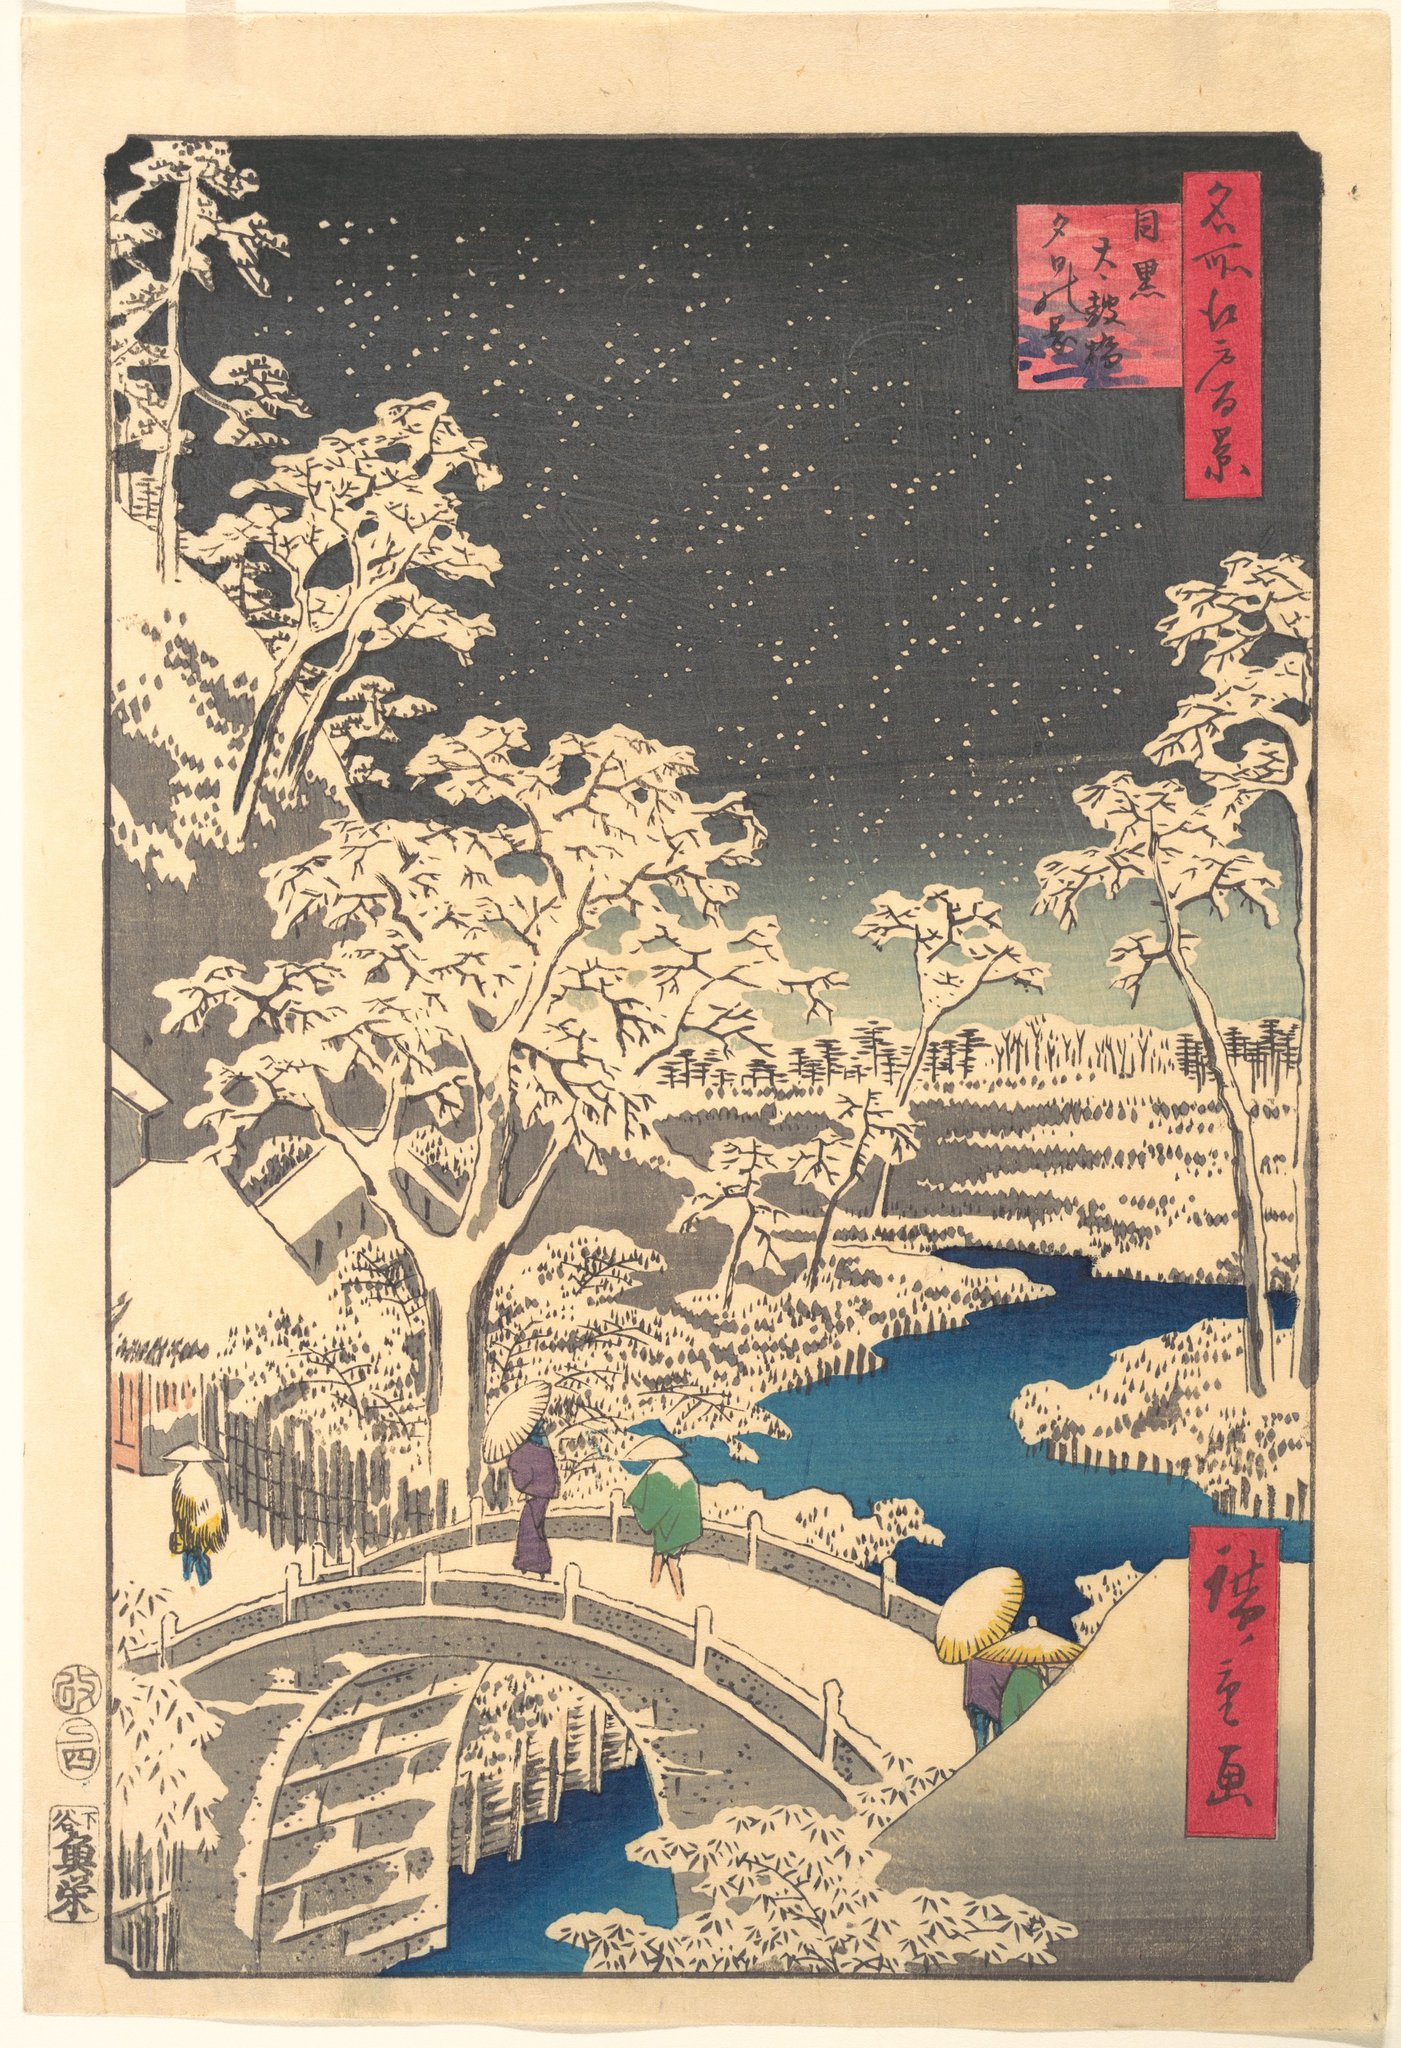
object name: print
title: Ochanomizu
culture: japanese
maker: utagawa hiroshige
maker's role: artist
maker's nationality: japanese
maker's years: 1797-1858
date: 1867-1900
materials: ink, paper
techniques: woodblock print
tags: human figures,bridges,landscapes,snow,streams